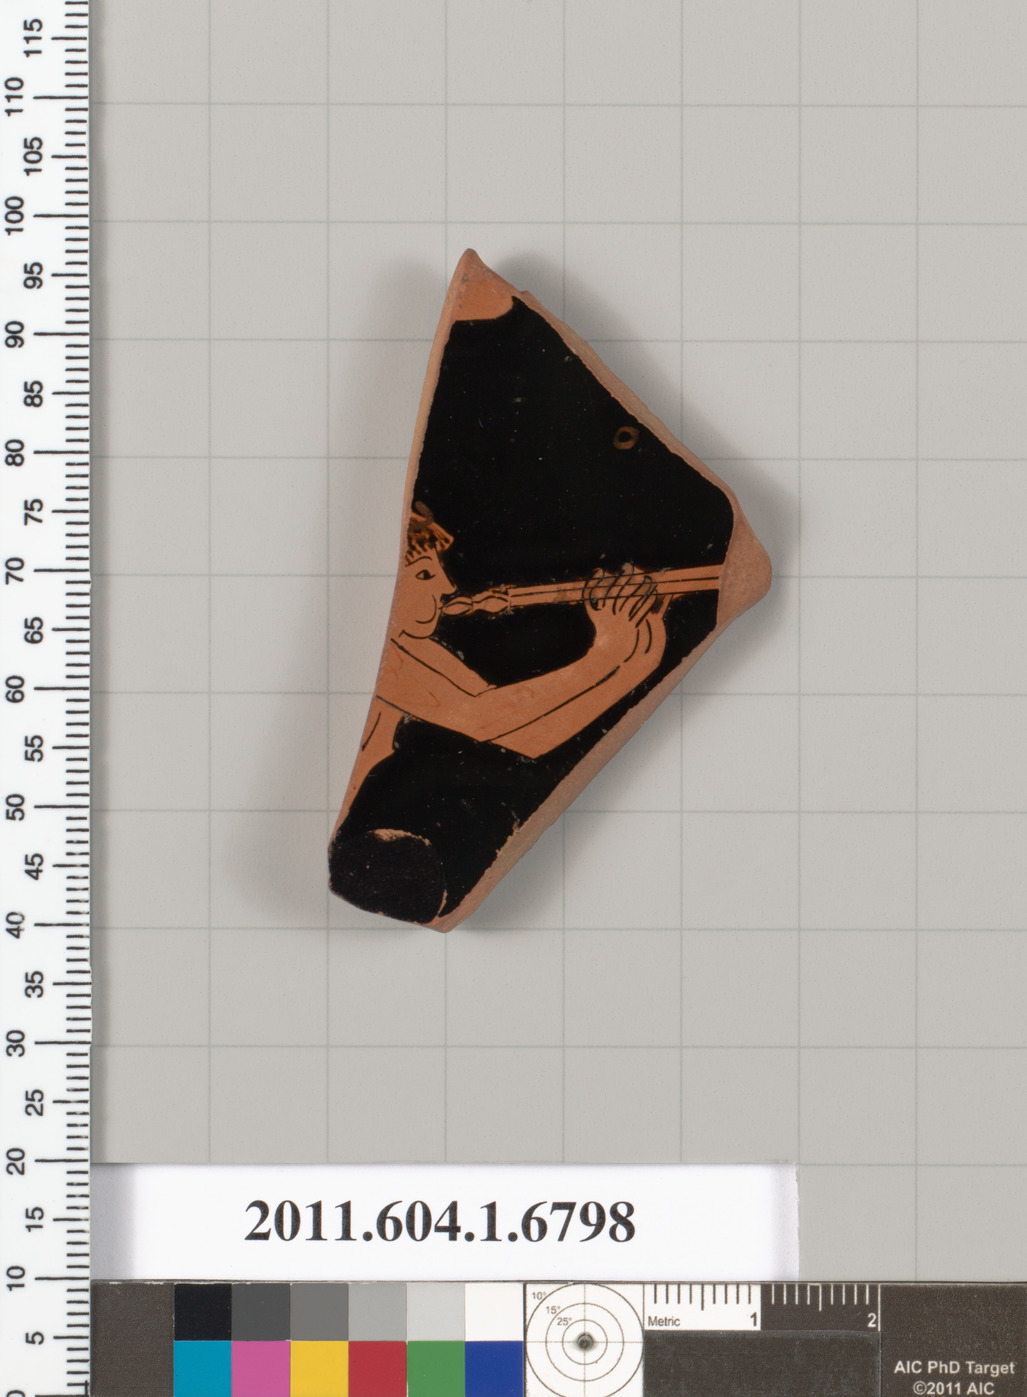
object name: kylix fragment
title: Terracotta fragment of a kylix (drinking cup)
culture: greek, attic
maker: brygos painter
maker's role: artist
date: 490-470 BCE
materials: terracotta